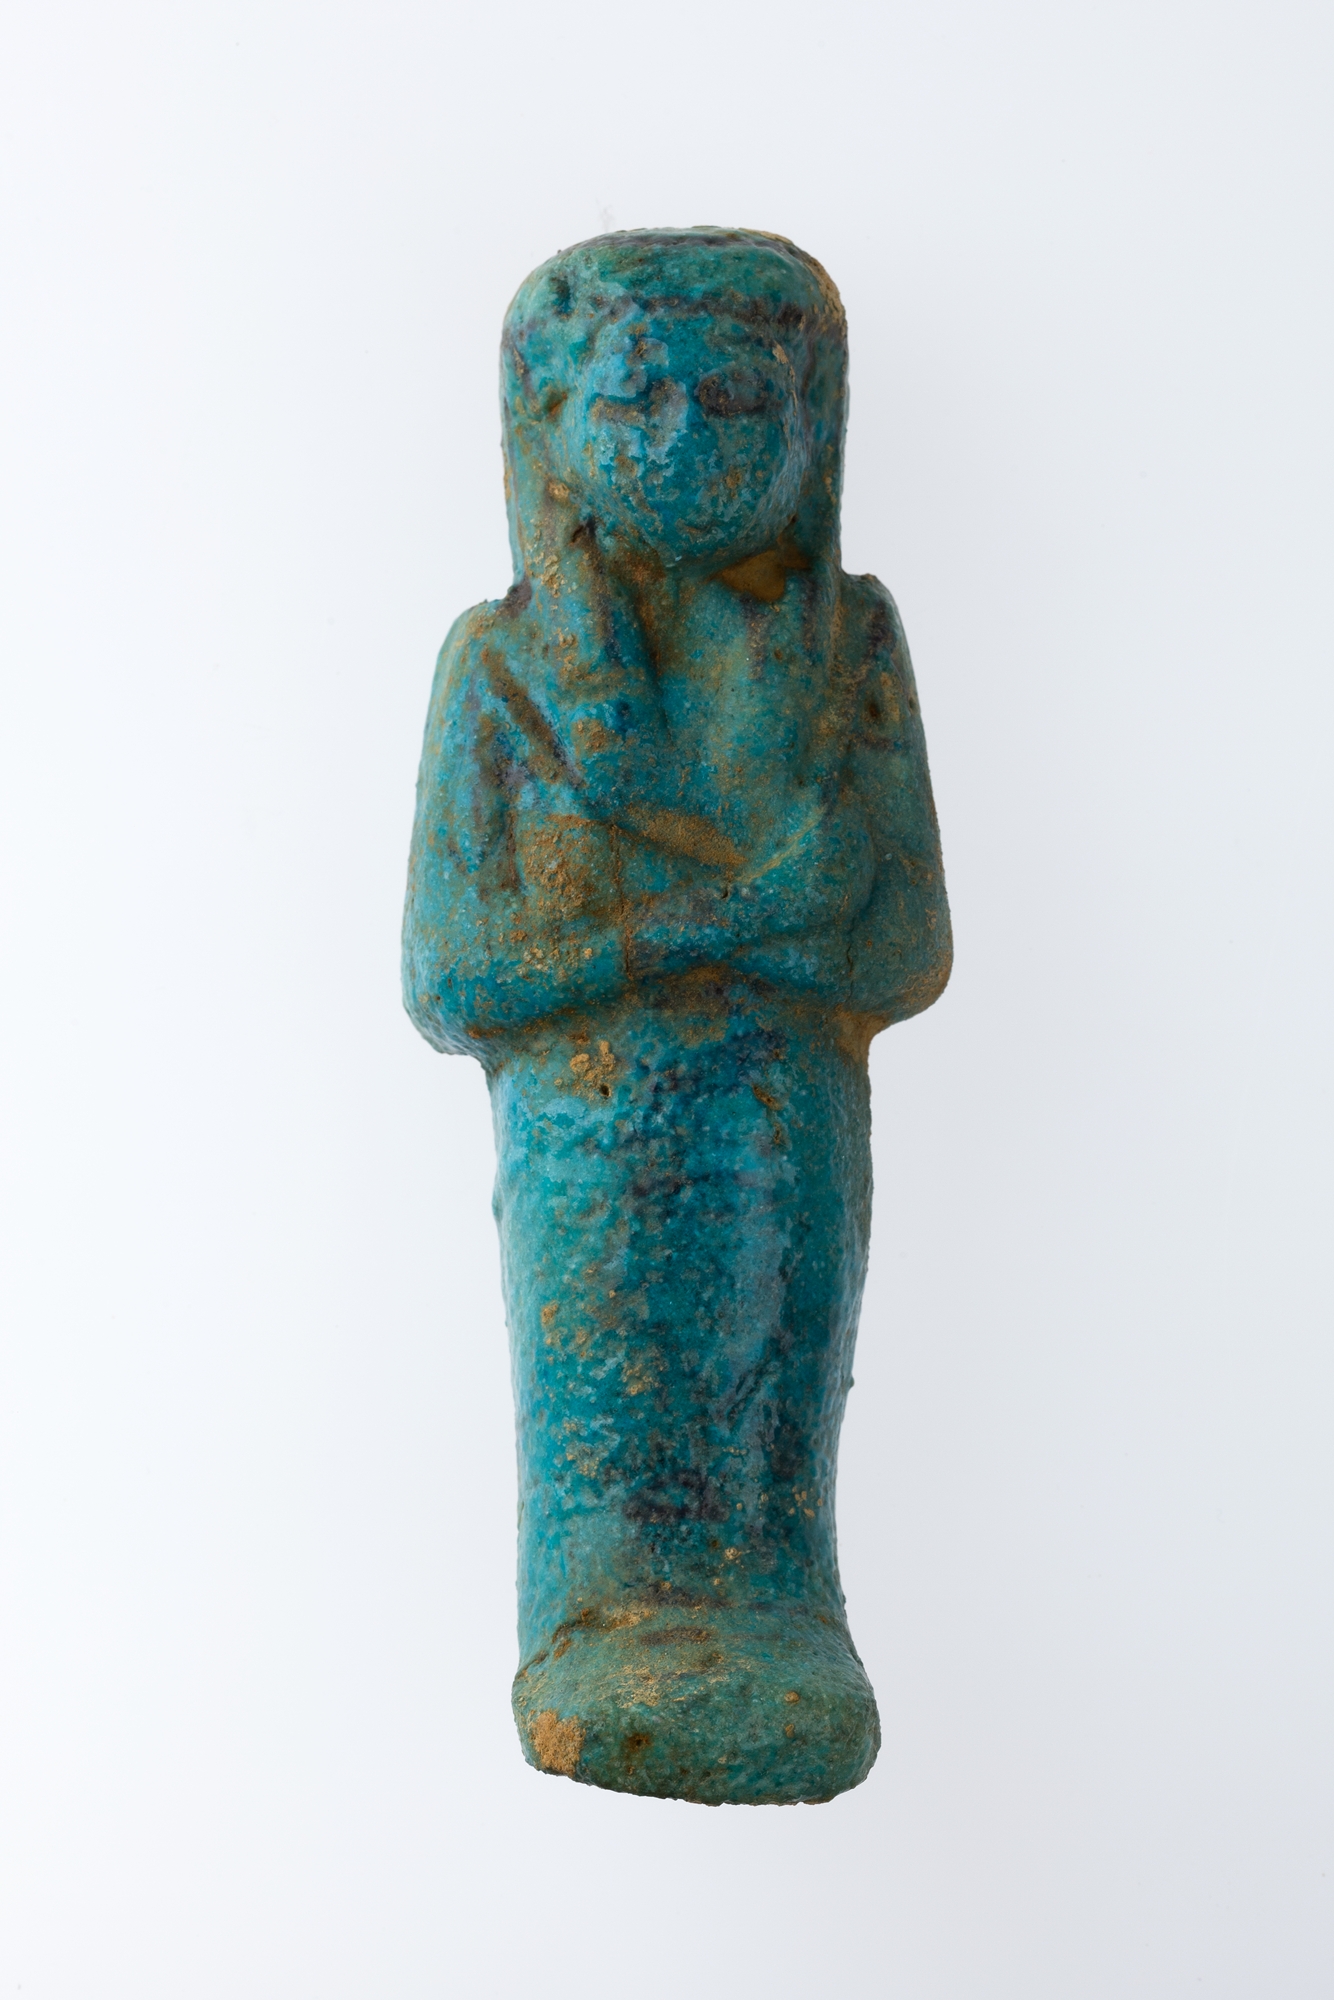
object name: shabti, henettawy c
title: Worker Shabti of Henettawy (C), Daughter of Isetemkheb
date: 990-970 BCE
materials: faience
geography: egypt